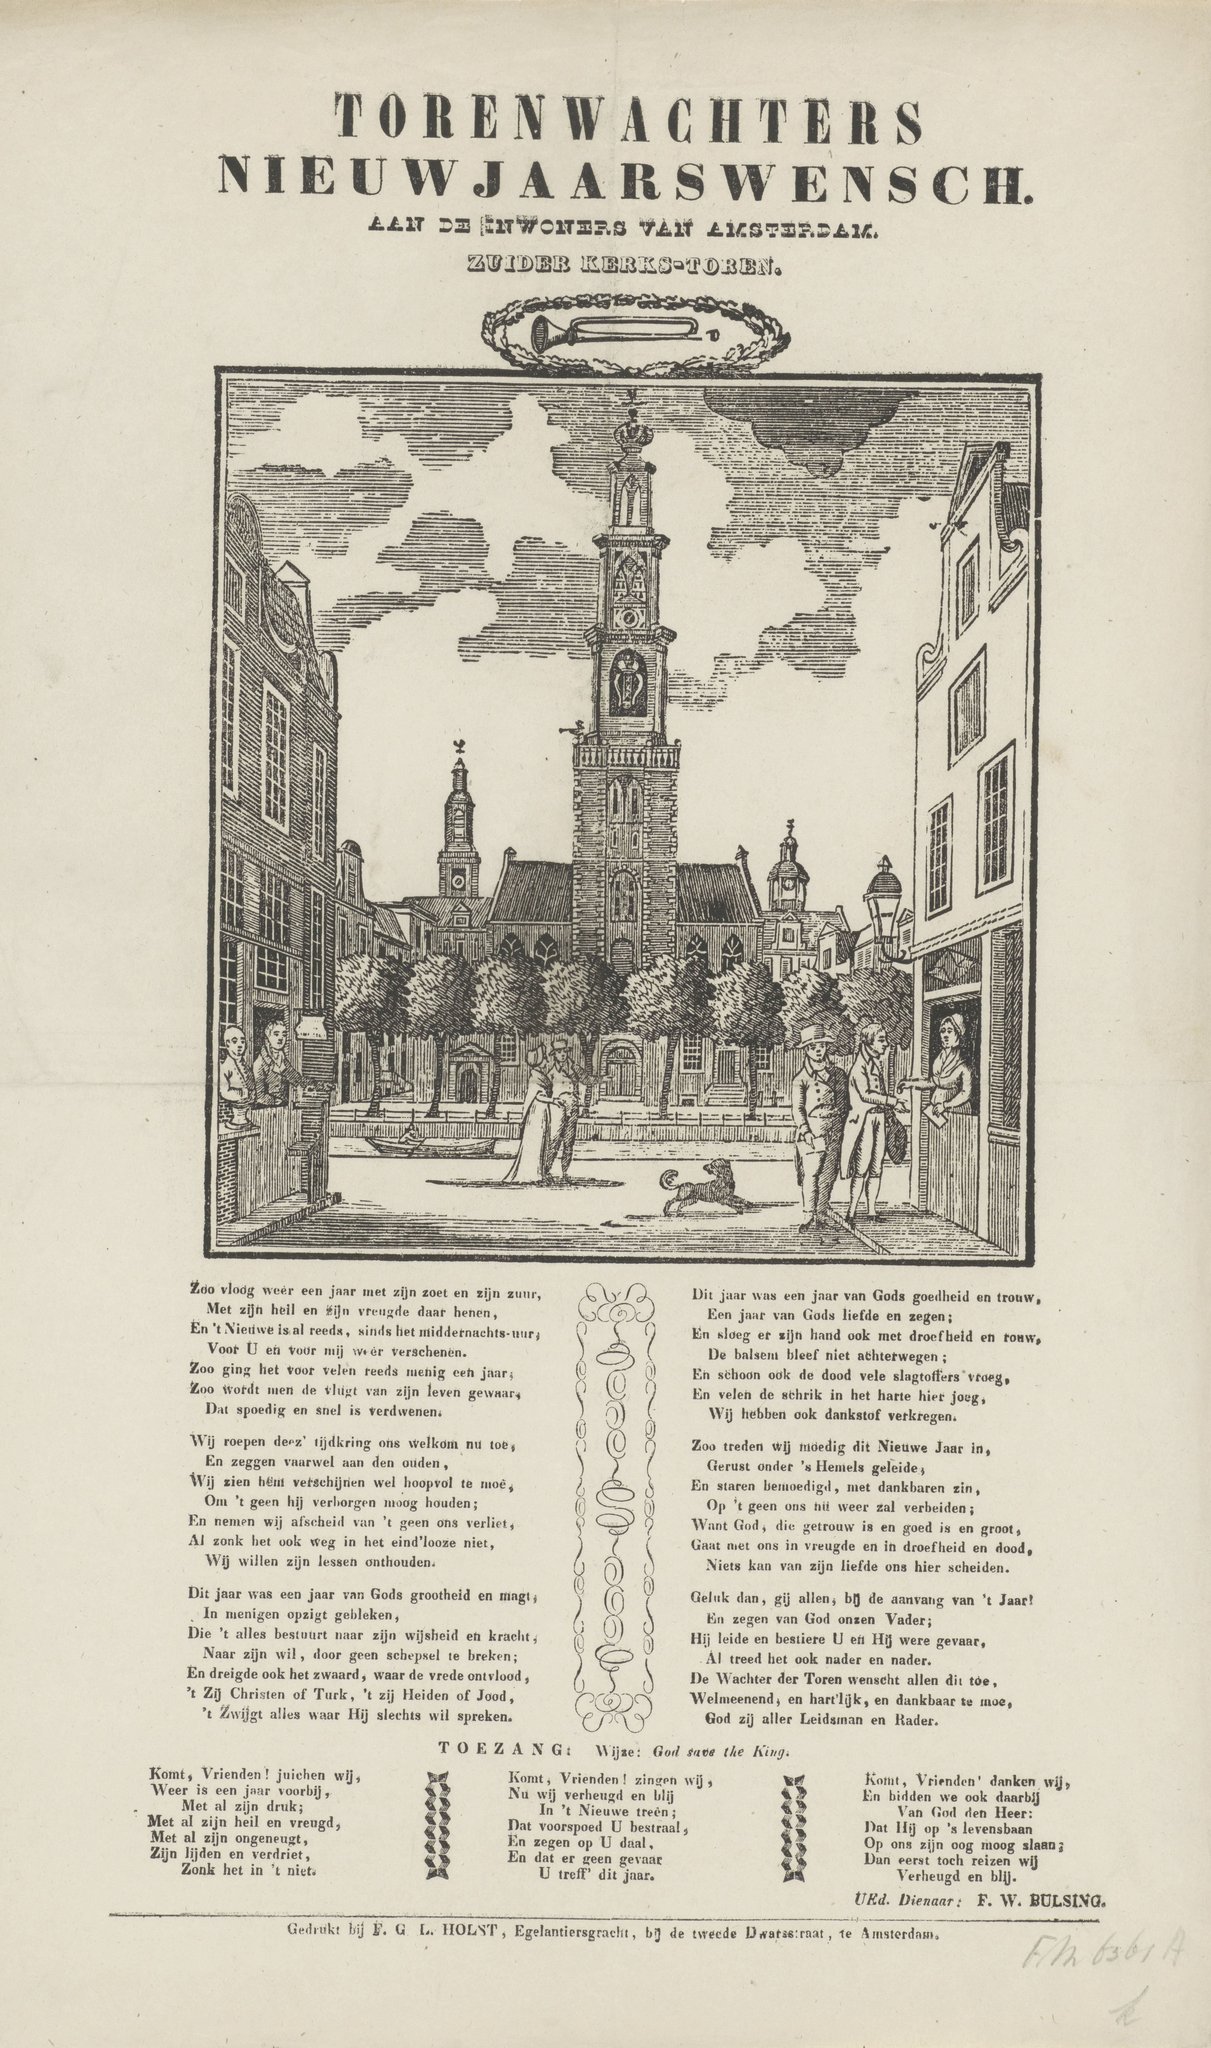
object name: new year card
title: Torenwachters Nieuwjaarswensch (...) Zuider Kerks-toren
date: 1840-1870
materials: paper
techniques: letterpress printing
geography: amsterdam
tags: tower sentry, street, amsterdam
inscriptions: collector's mark: Lugt 2228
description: Nieuwjaarswens van de torenwachters van de Amsterdamse Zuiderkerk, ca. 1840-1870. Gezicht op de Westerkerk te Amsterdam, twee mannen halen aan de huizen geld op. Onderaan een gedicht in twee kolommen en een lied in drie verzen. Van de torenwachter: F.W. Bulsing.